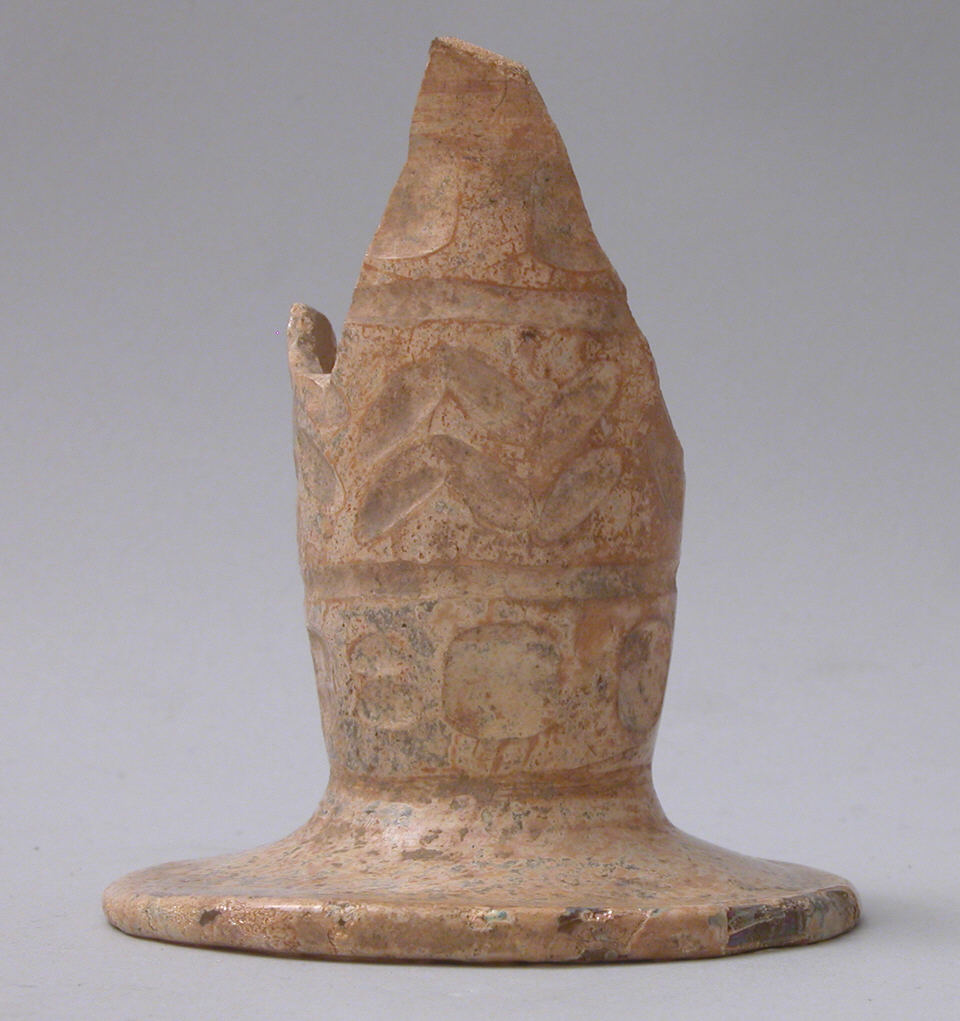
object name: bottle fragment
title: Bottle Neck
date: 901-1100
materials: glass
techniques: glassblowing, cutting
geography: iraq